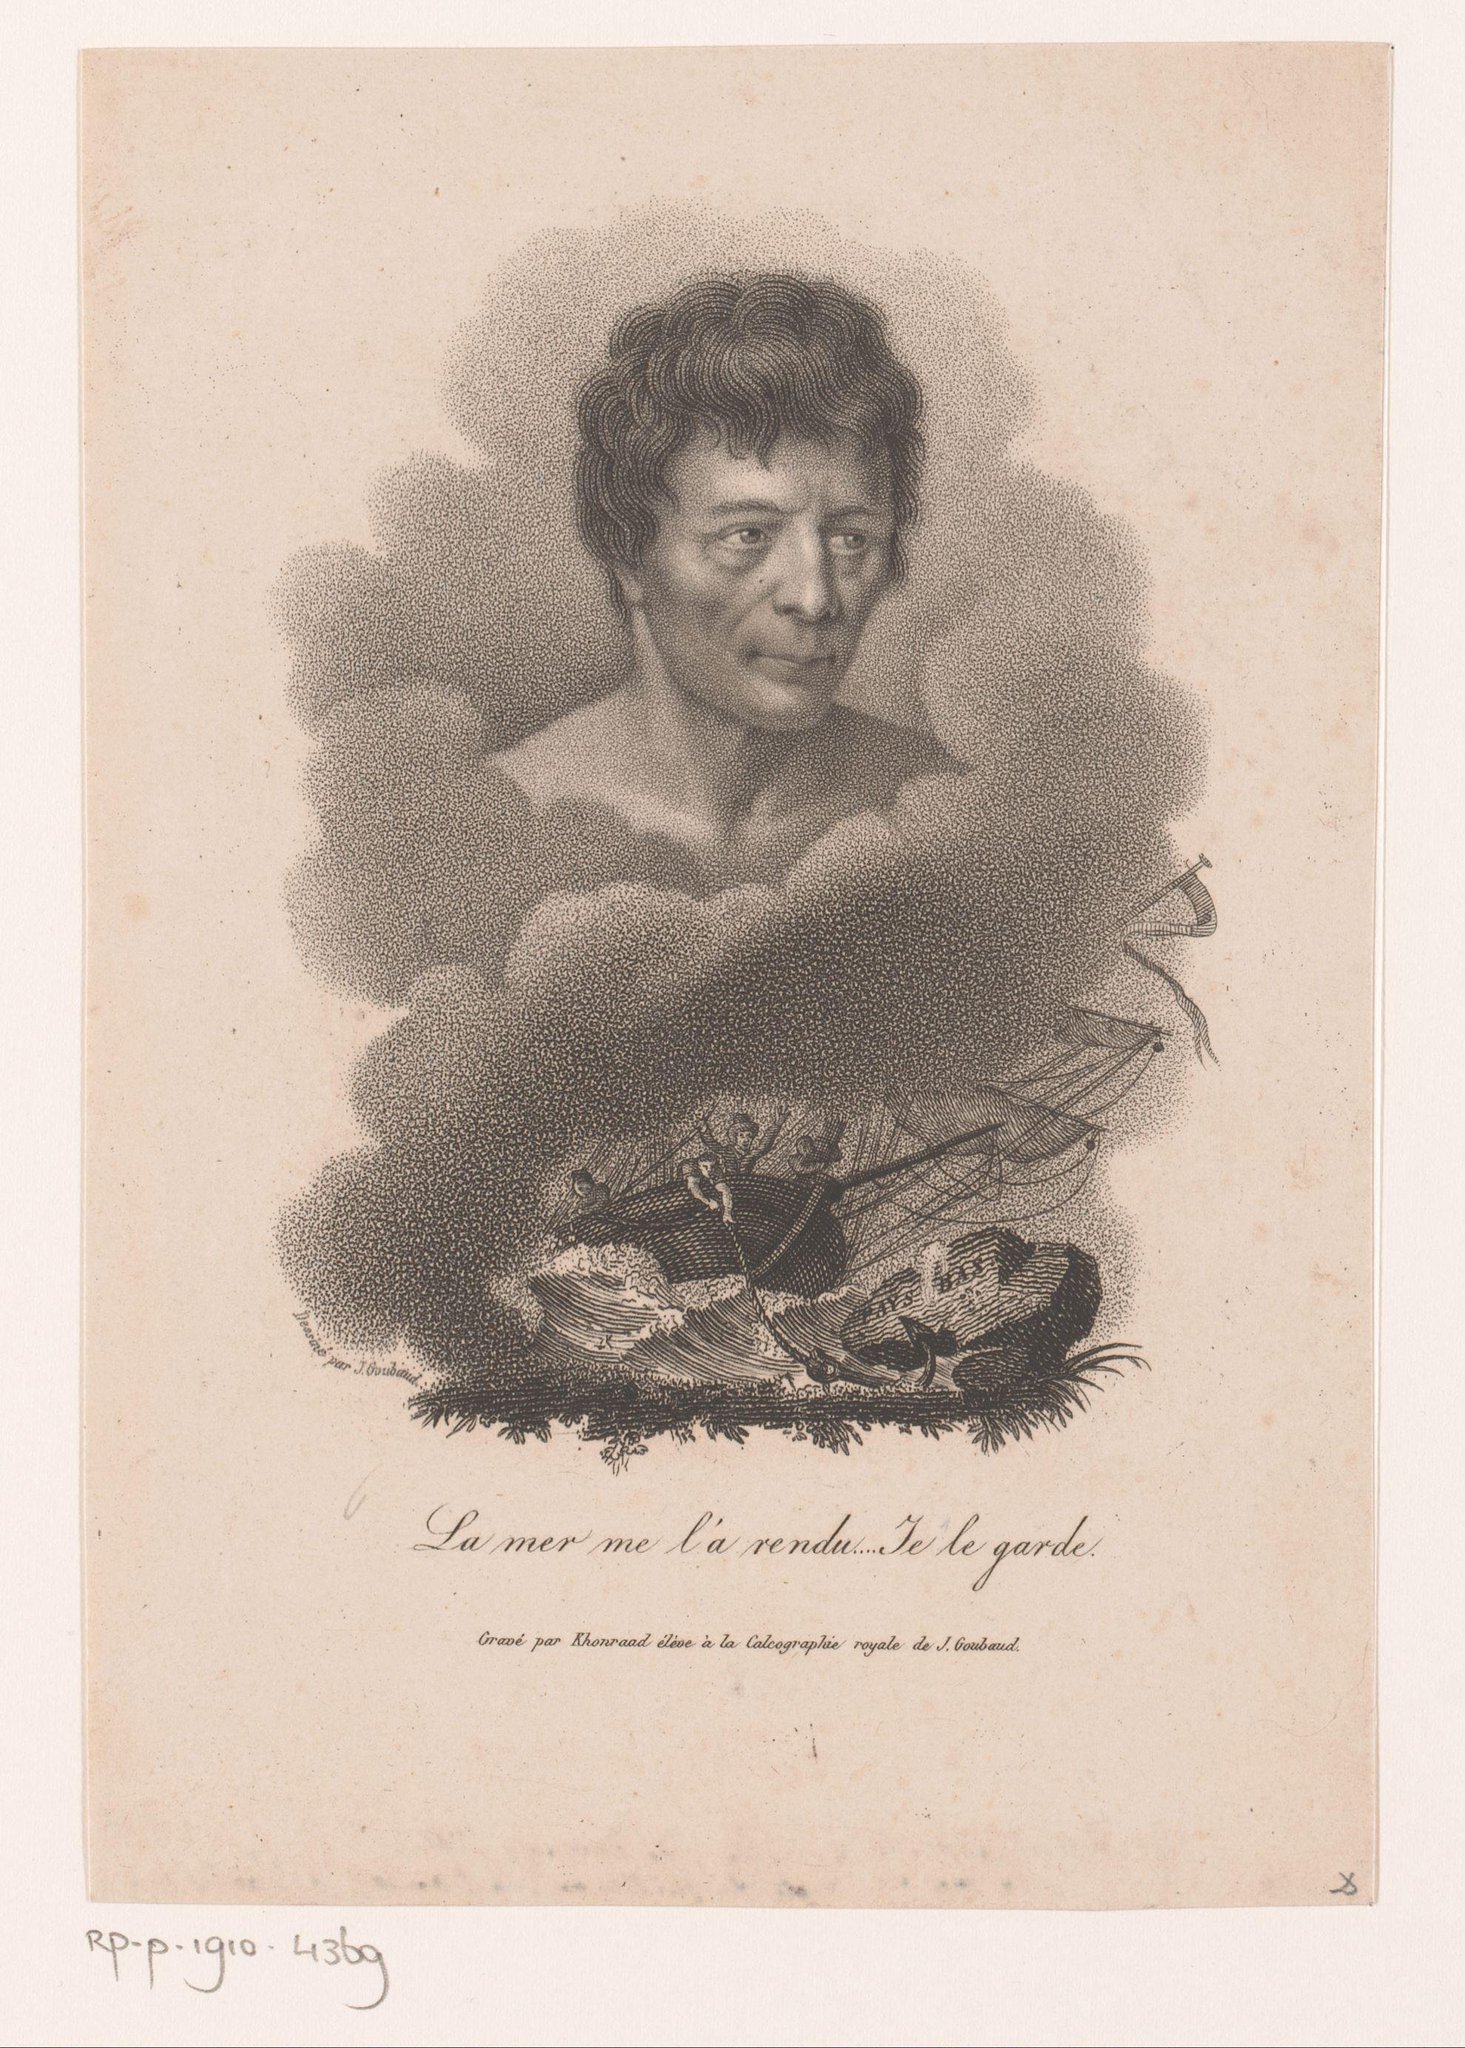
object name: print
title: Schipbreuk van Philippe-Antoine Merlin de Douai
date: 1830-1880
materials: paper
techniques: engraving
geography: southern netherlands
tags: paris, politician, historical persons, shipwreck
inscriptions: collector's mark: Lugt 2228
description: Borstbeeld van de Franse uitgewekene Merlin door wolken omgeven, daaronder zijn schipbreuk aan de Nederlandse kust in 1829. Op Franse verzoeken om uitlevering van Merlin antwoorde koning Willem I met de woorden 'La mer me l'a rendu ... Je le garde'.